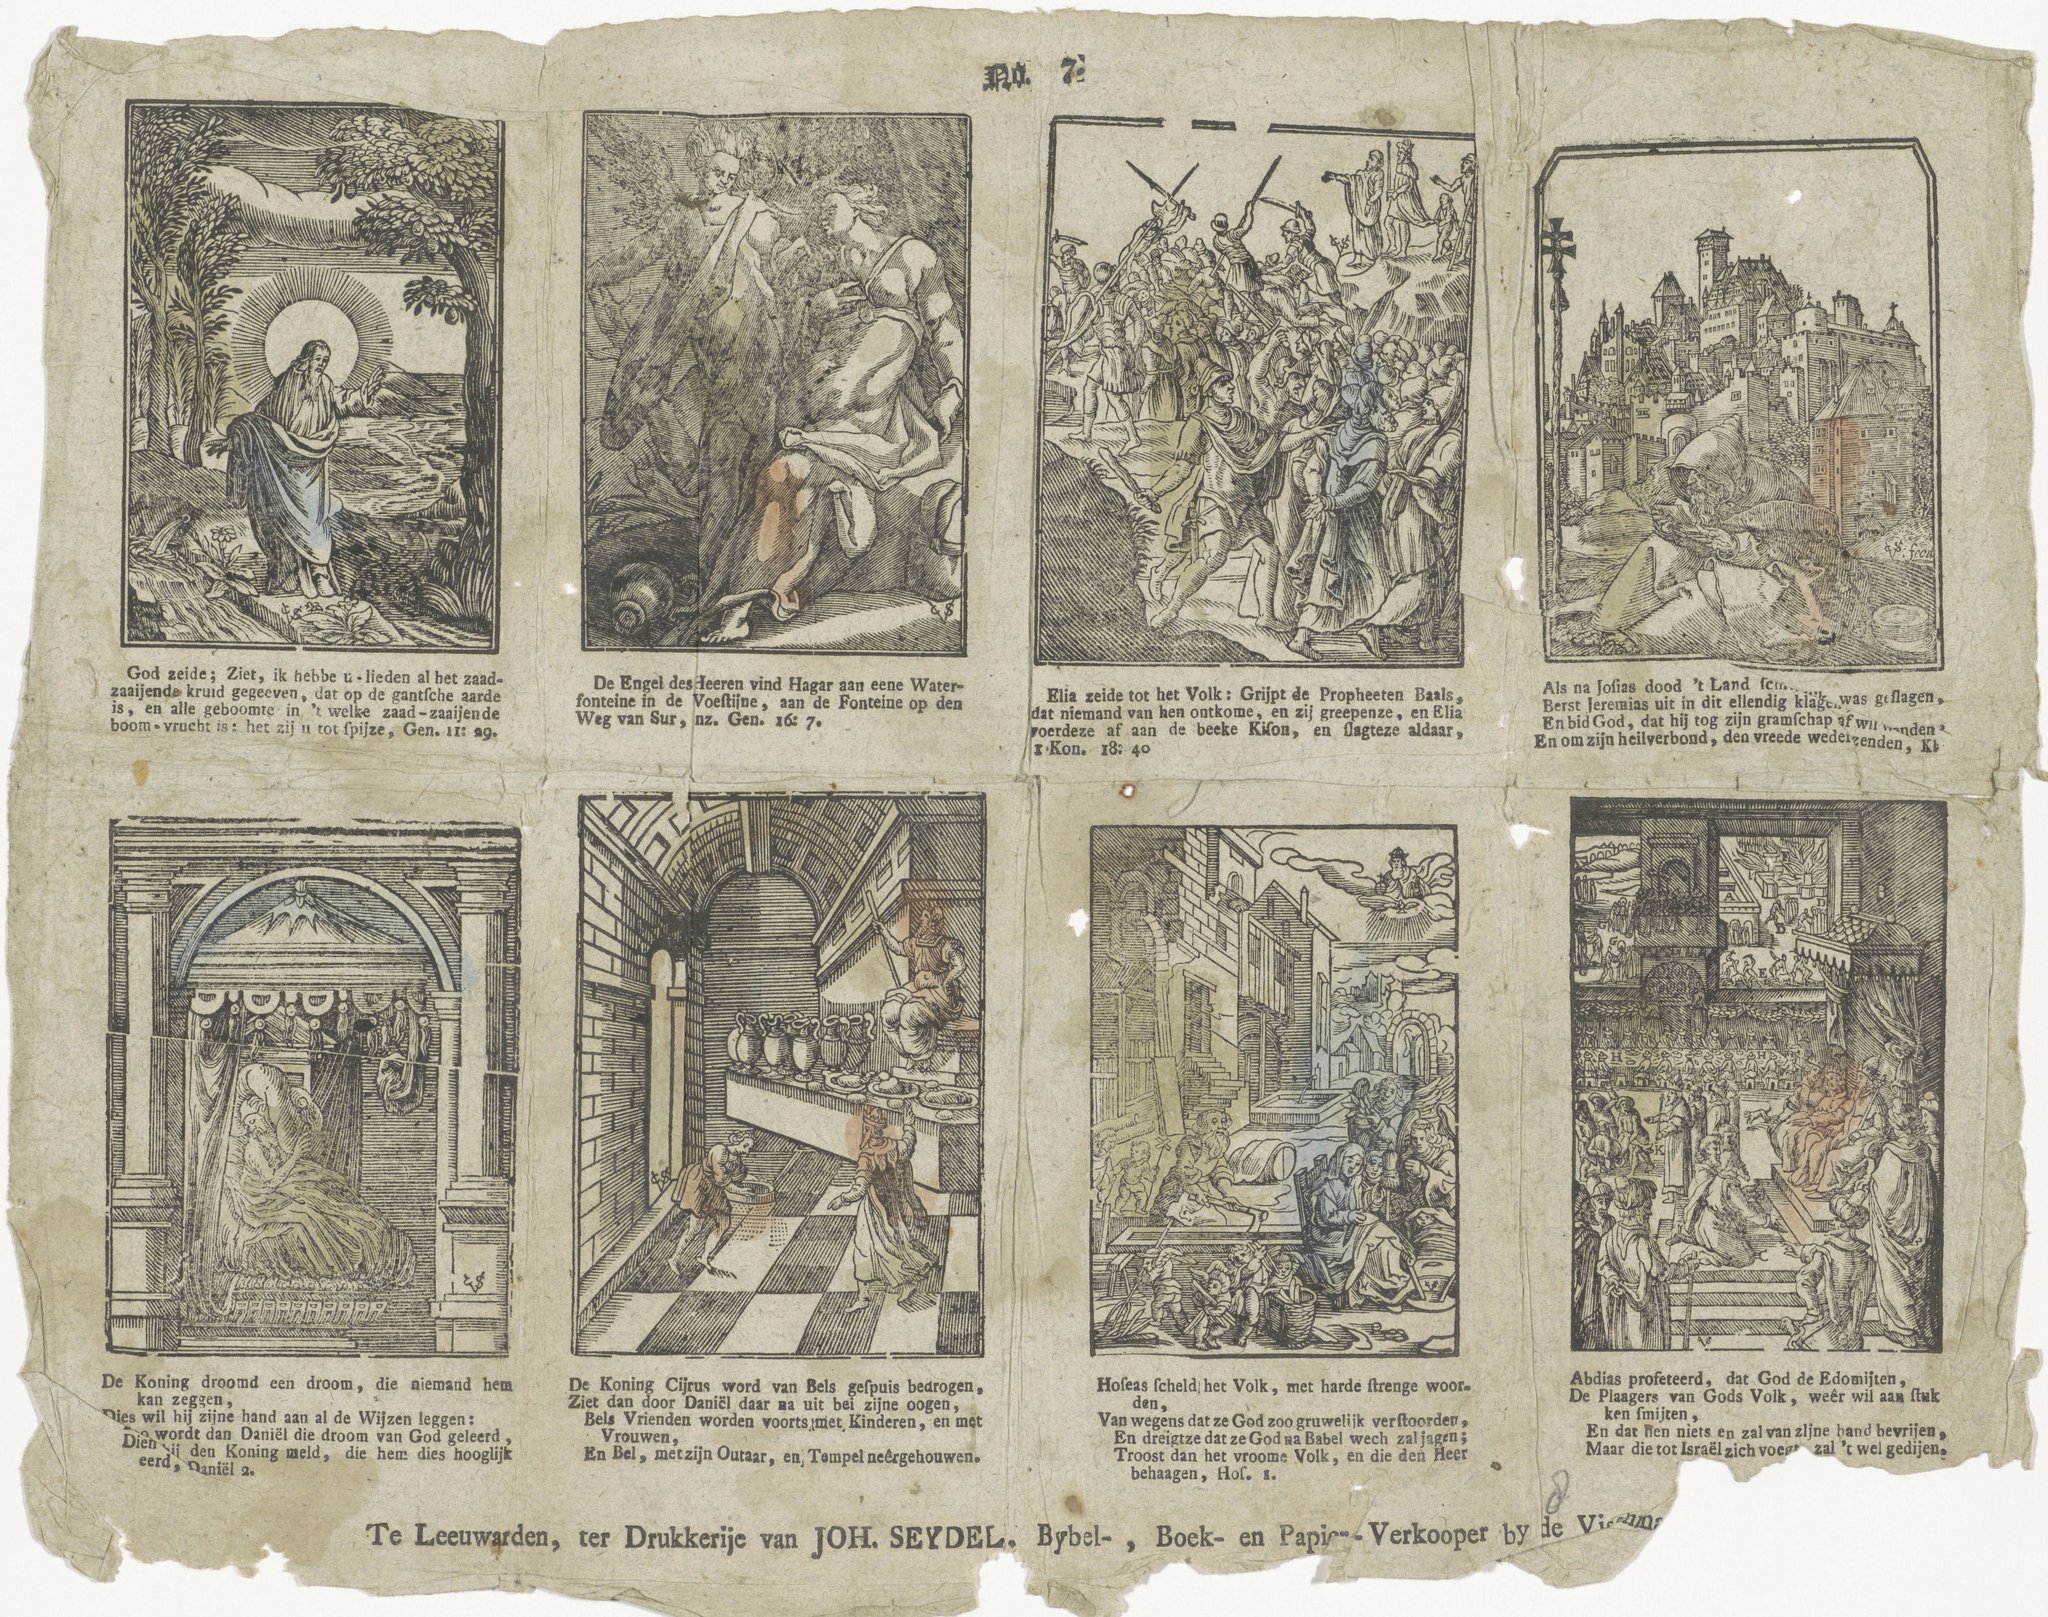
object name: print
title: Taferelen uit het Oude Testament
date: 1776-1813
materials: paper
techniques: colour, letterpress printing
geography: netherlands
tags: old testament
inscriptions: collector's mark: Lugt 2228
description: Blad met 8 voorstellingen van verhalen uit het Oude Testament. Onder elke afbeelding een onderschrift. Genummerd midden boven: No. 7.